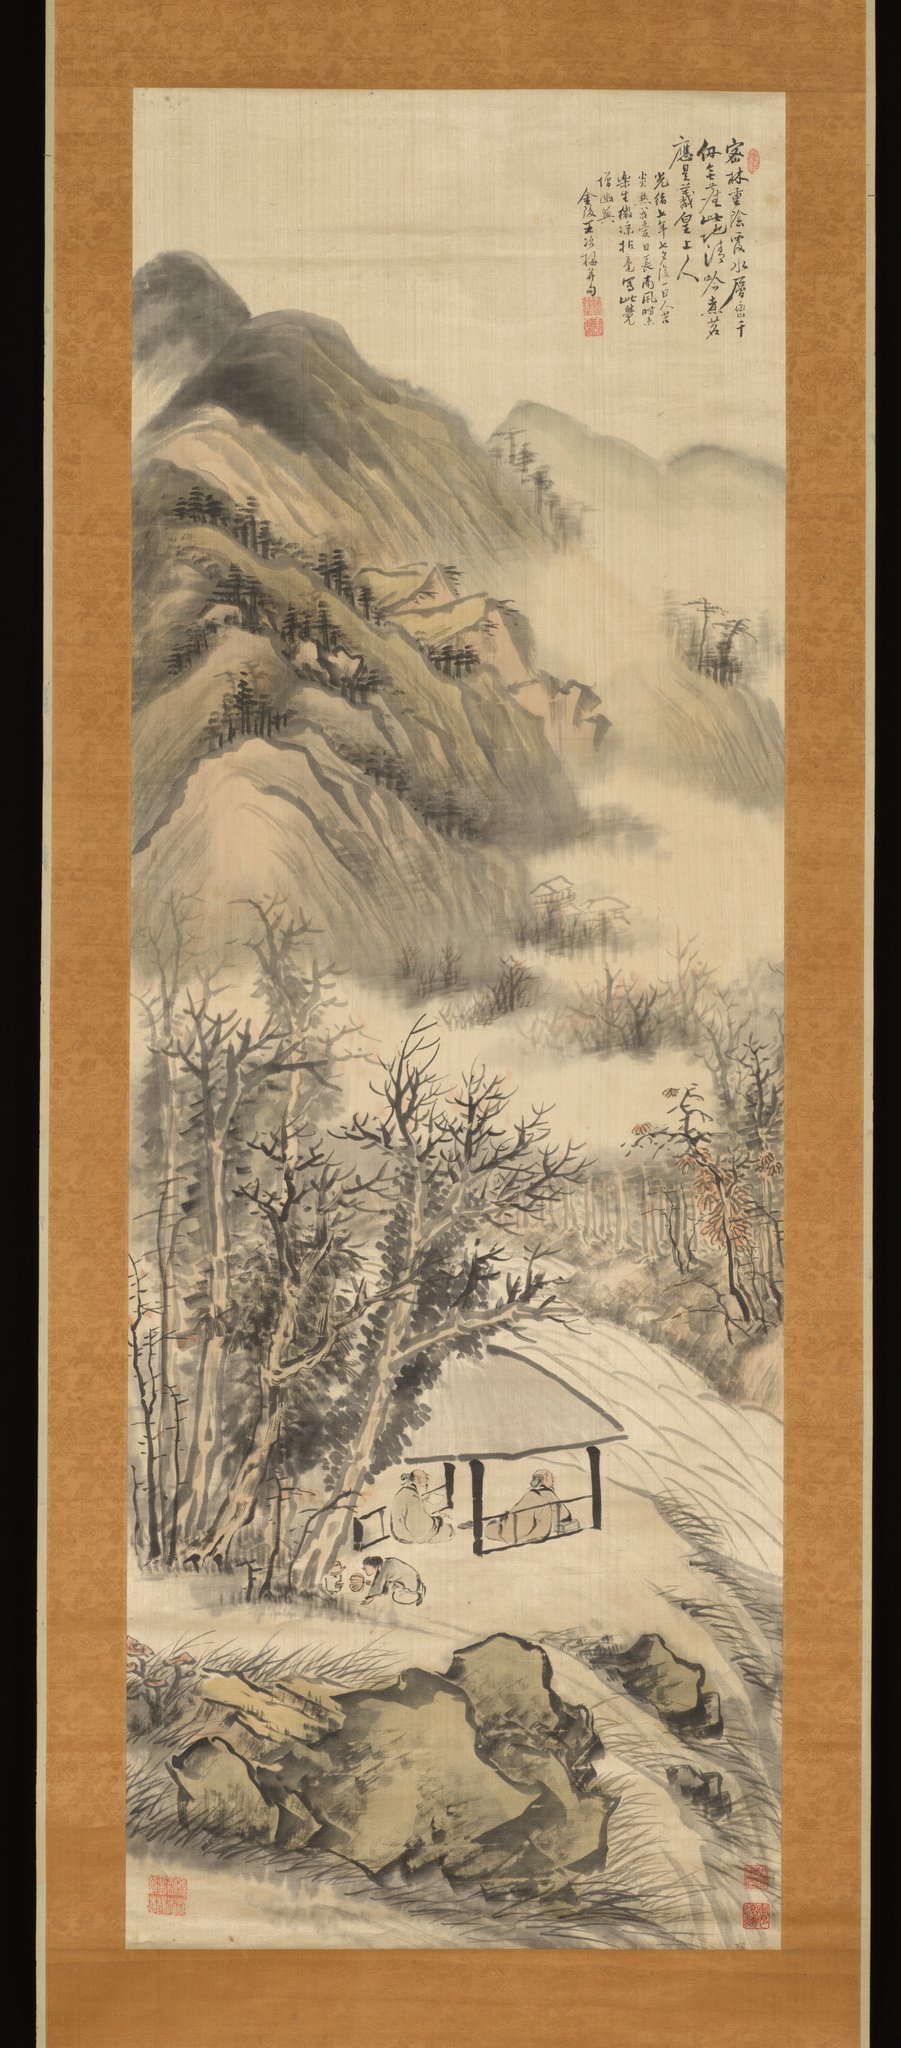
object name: hanging scroll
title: Landscape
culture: chinese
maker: wang yin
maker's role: artist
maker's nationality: chinese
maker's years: 1850-1899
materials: ink, textile